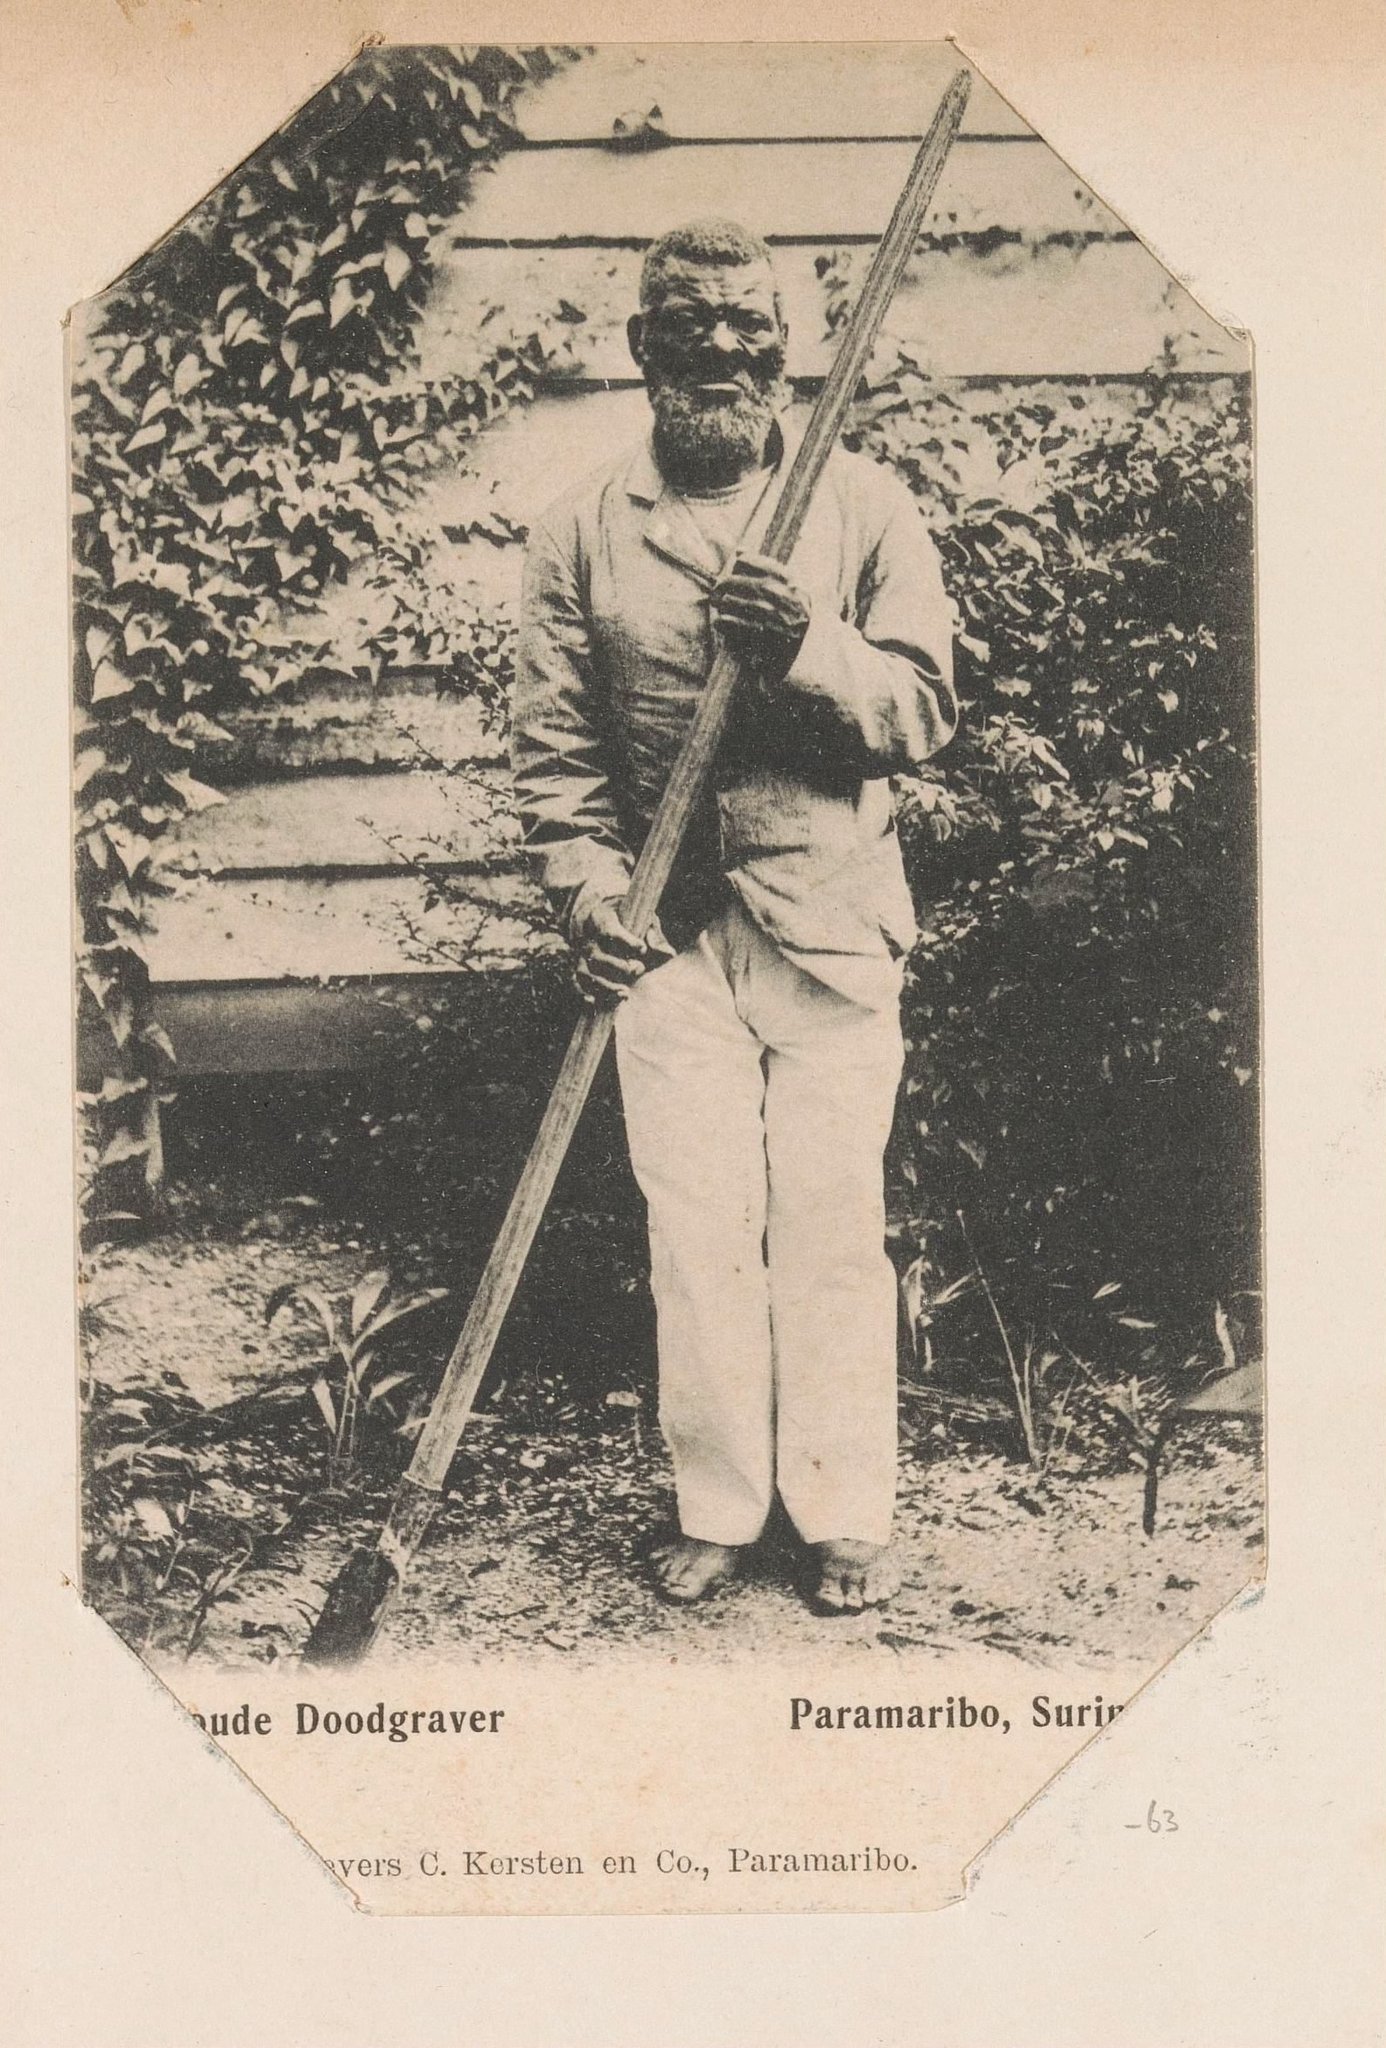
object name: ansichtkaart, prentbriefkaart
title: Portret van een doodgraver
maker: Anonymous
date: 1900-1910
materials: cardboard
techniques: photograph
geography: paramaribo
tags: standing figure, old man, grave digger, suriname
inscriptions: serial number: ‘No. 64. Uitgevers C. Kersten & Co., Paramaribo’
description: Portret van een oude Surinaamse man, werkzaam als doodgraver. Onderdeel van een verzameling van 68 briefkaarten uit Suriname, bijeengebracht in een album als aandenken aan een verblijf in Suriname in september 1911.